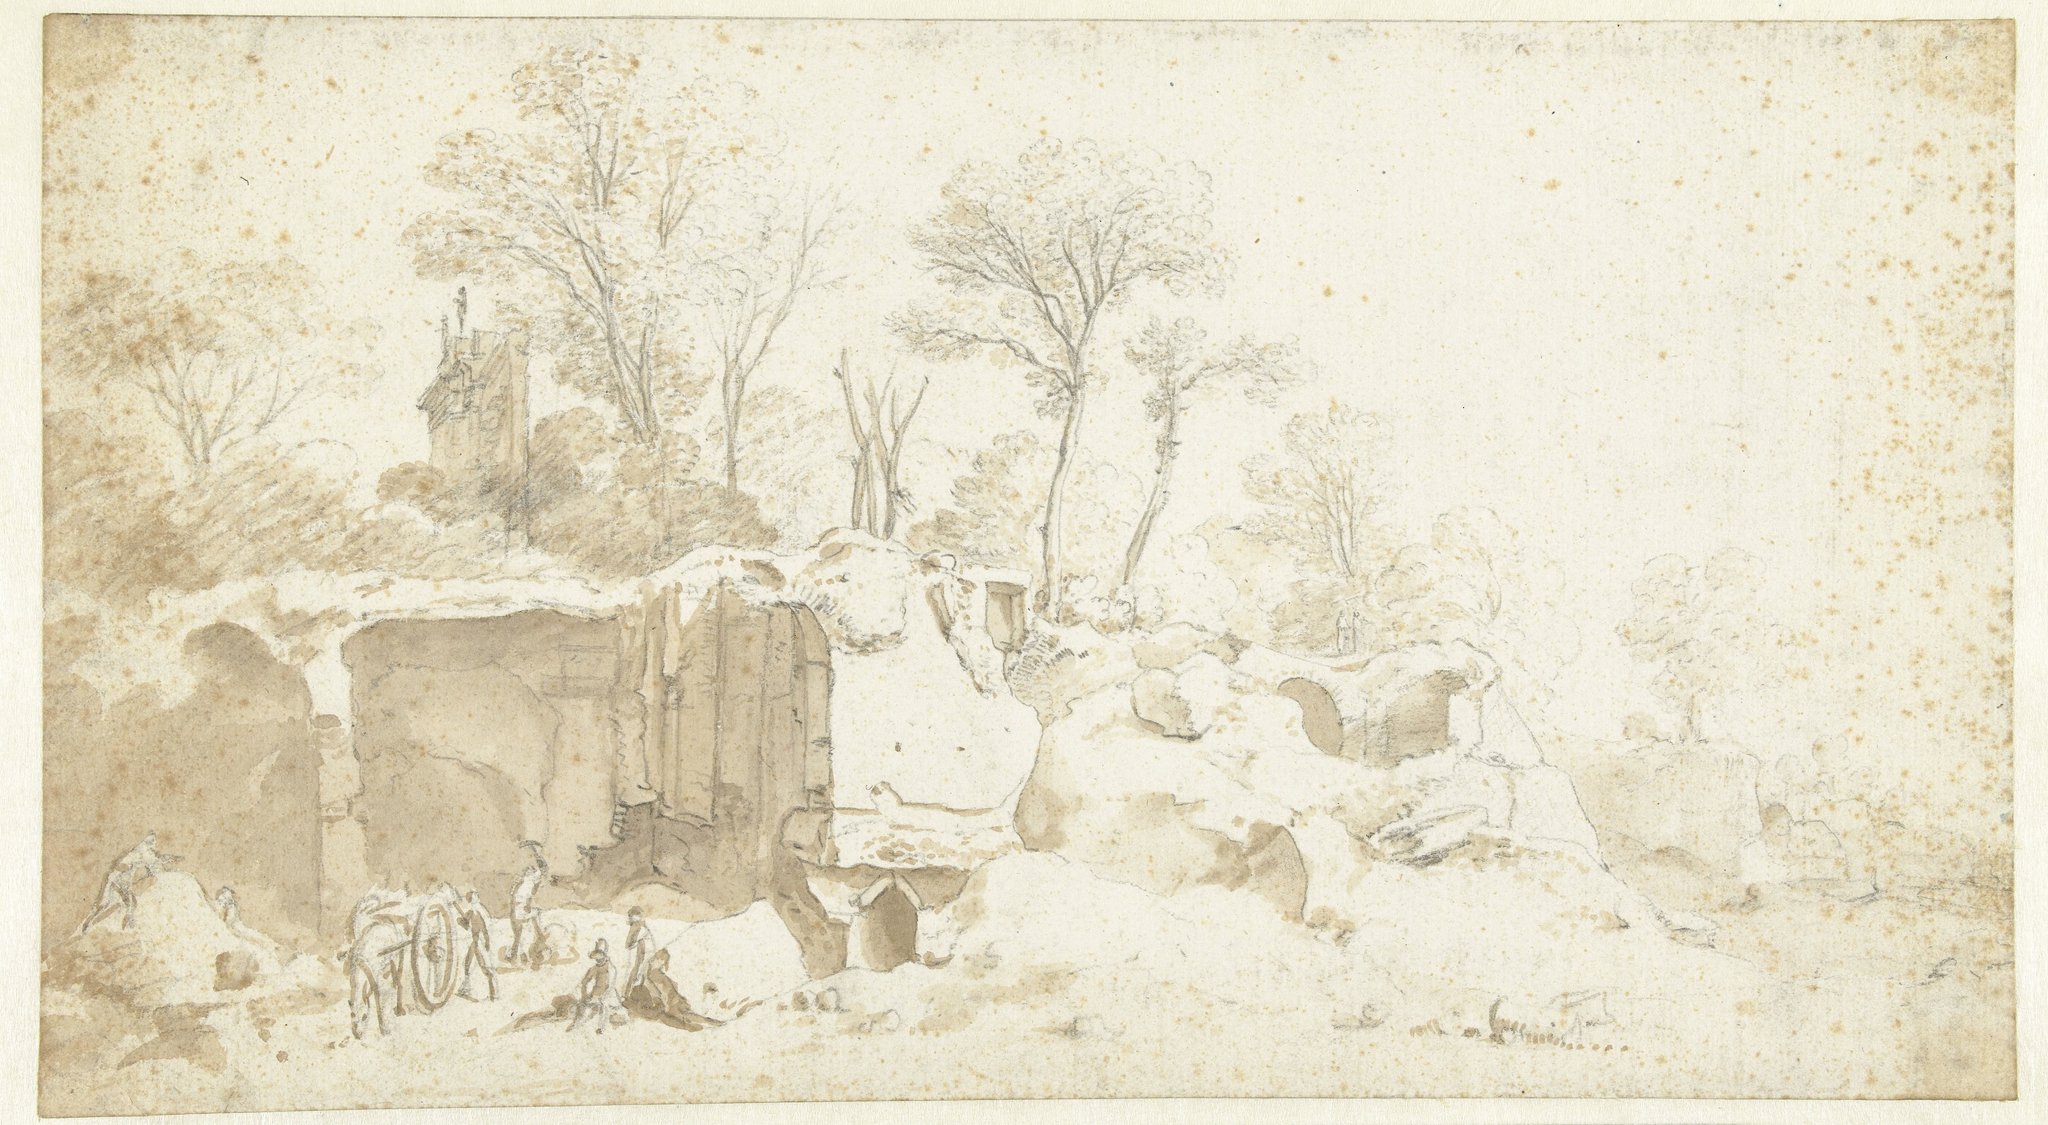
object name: drawing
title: Het uitgraven van antieke ruïnes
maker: herman van swanevelt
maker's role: draughtsman, painter, print maker, publisher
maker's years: 1603-1655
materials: paper, pencil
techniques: brush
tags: ruin of a building ~ architecture, landscape with ruins, demolition of building